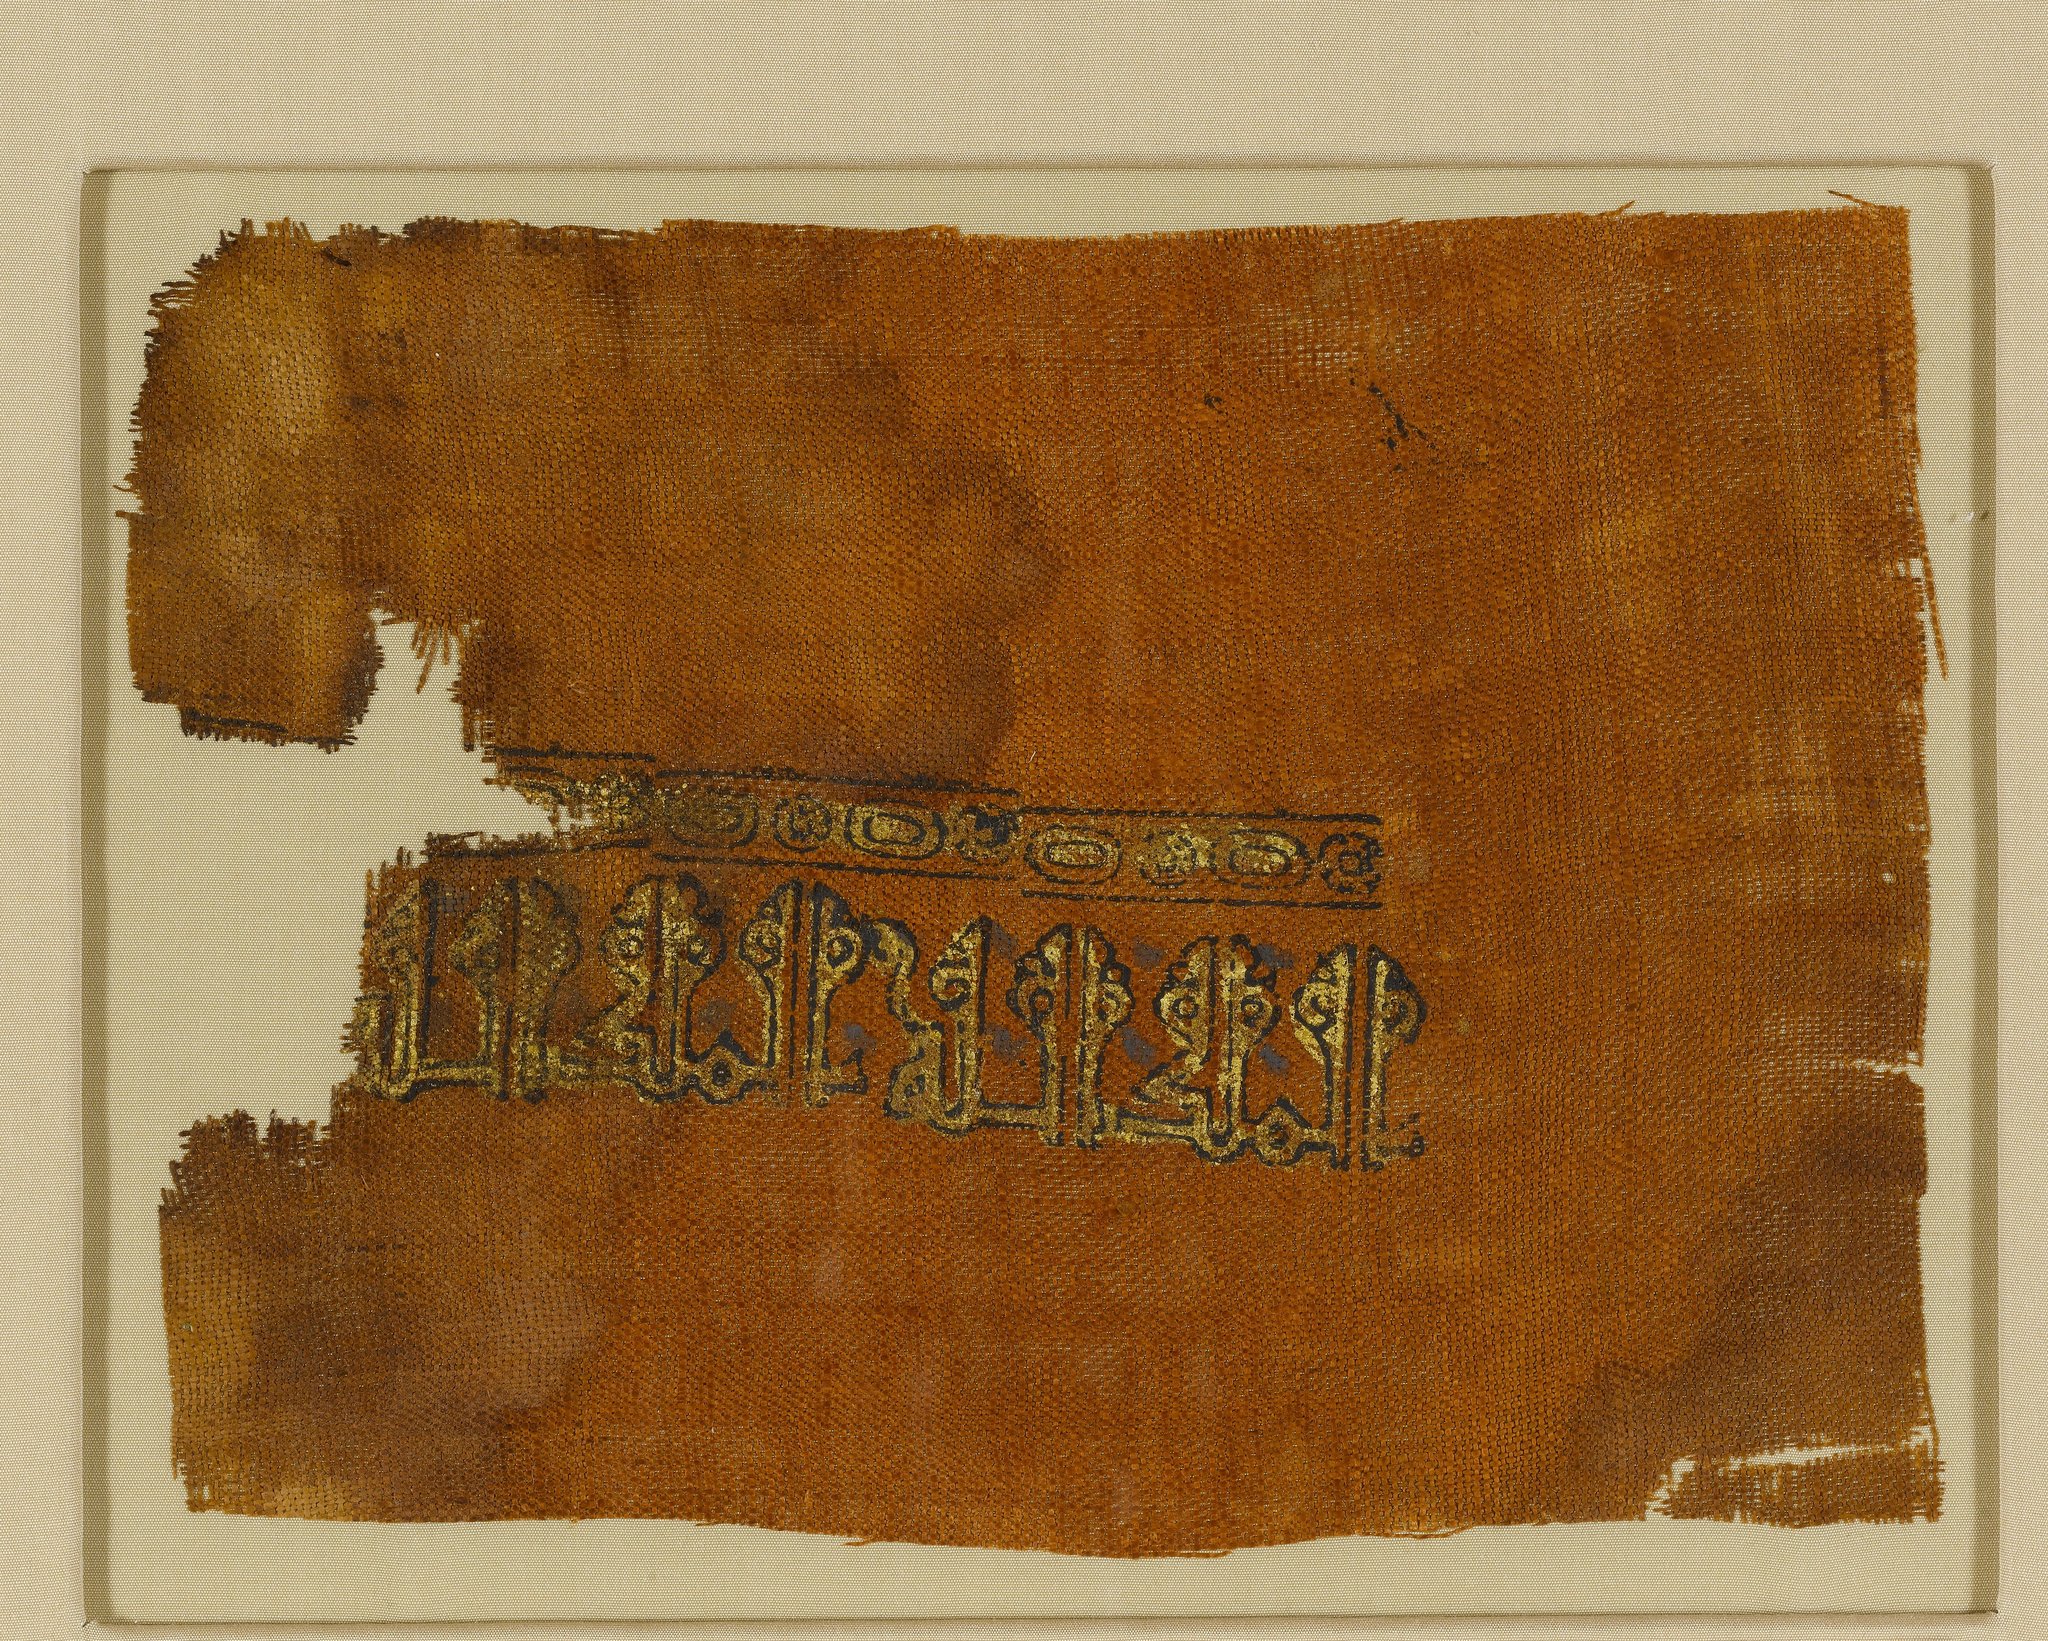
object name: textile fragment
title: Textile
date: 901-1100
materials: gold, ink, linen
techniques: painting, weave, printing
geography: egypt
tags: arabic